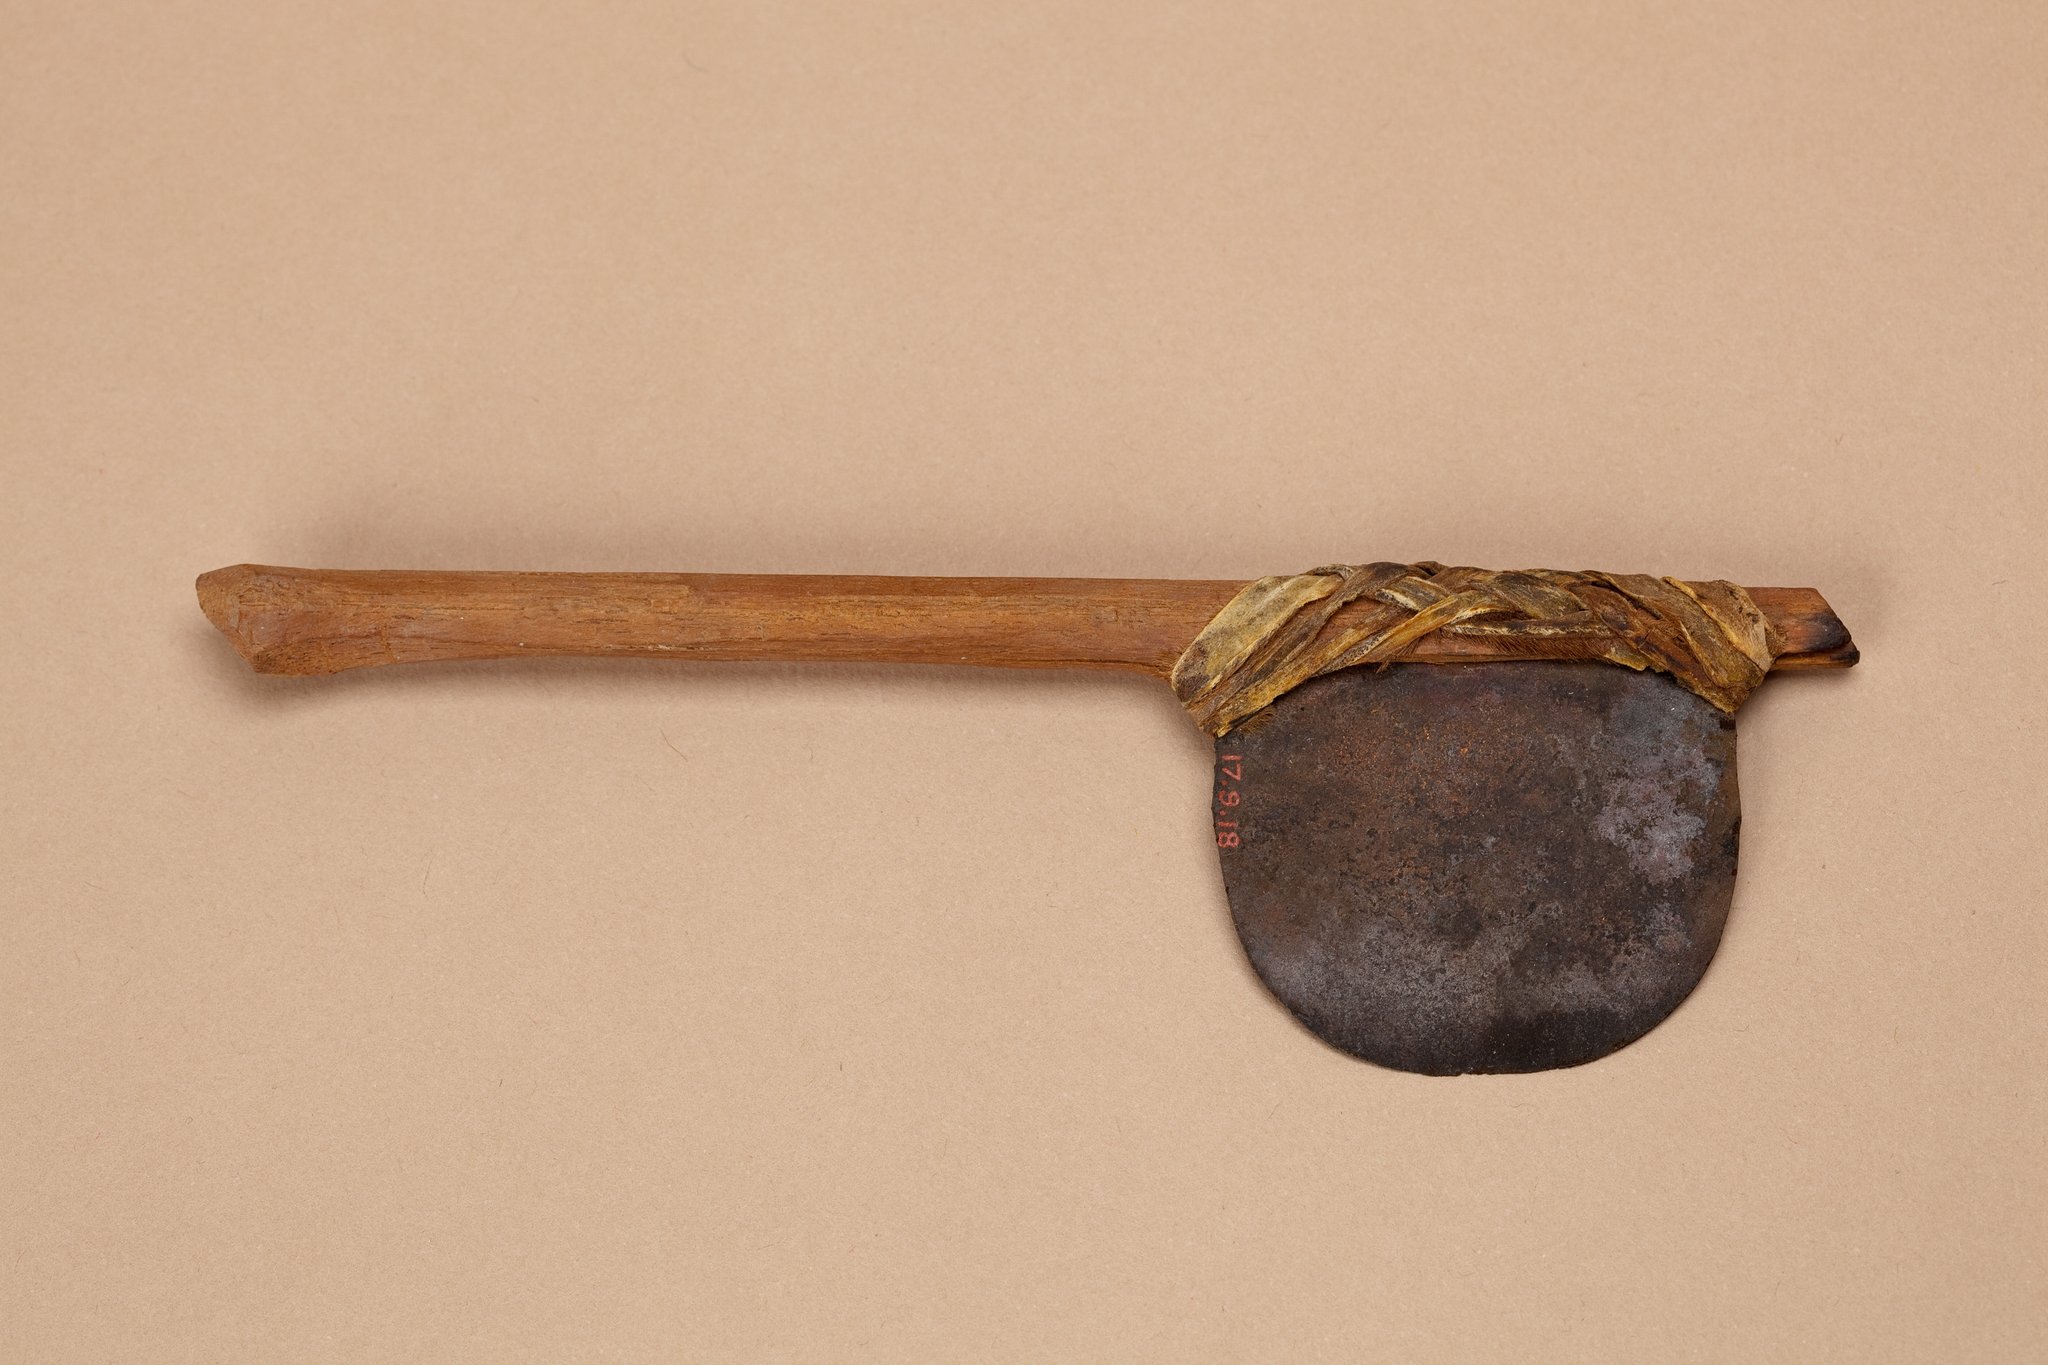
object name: model ax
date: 1981-1802 BCE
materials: copper, wood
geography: egypt